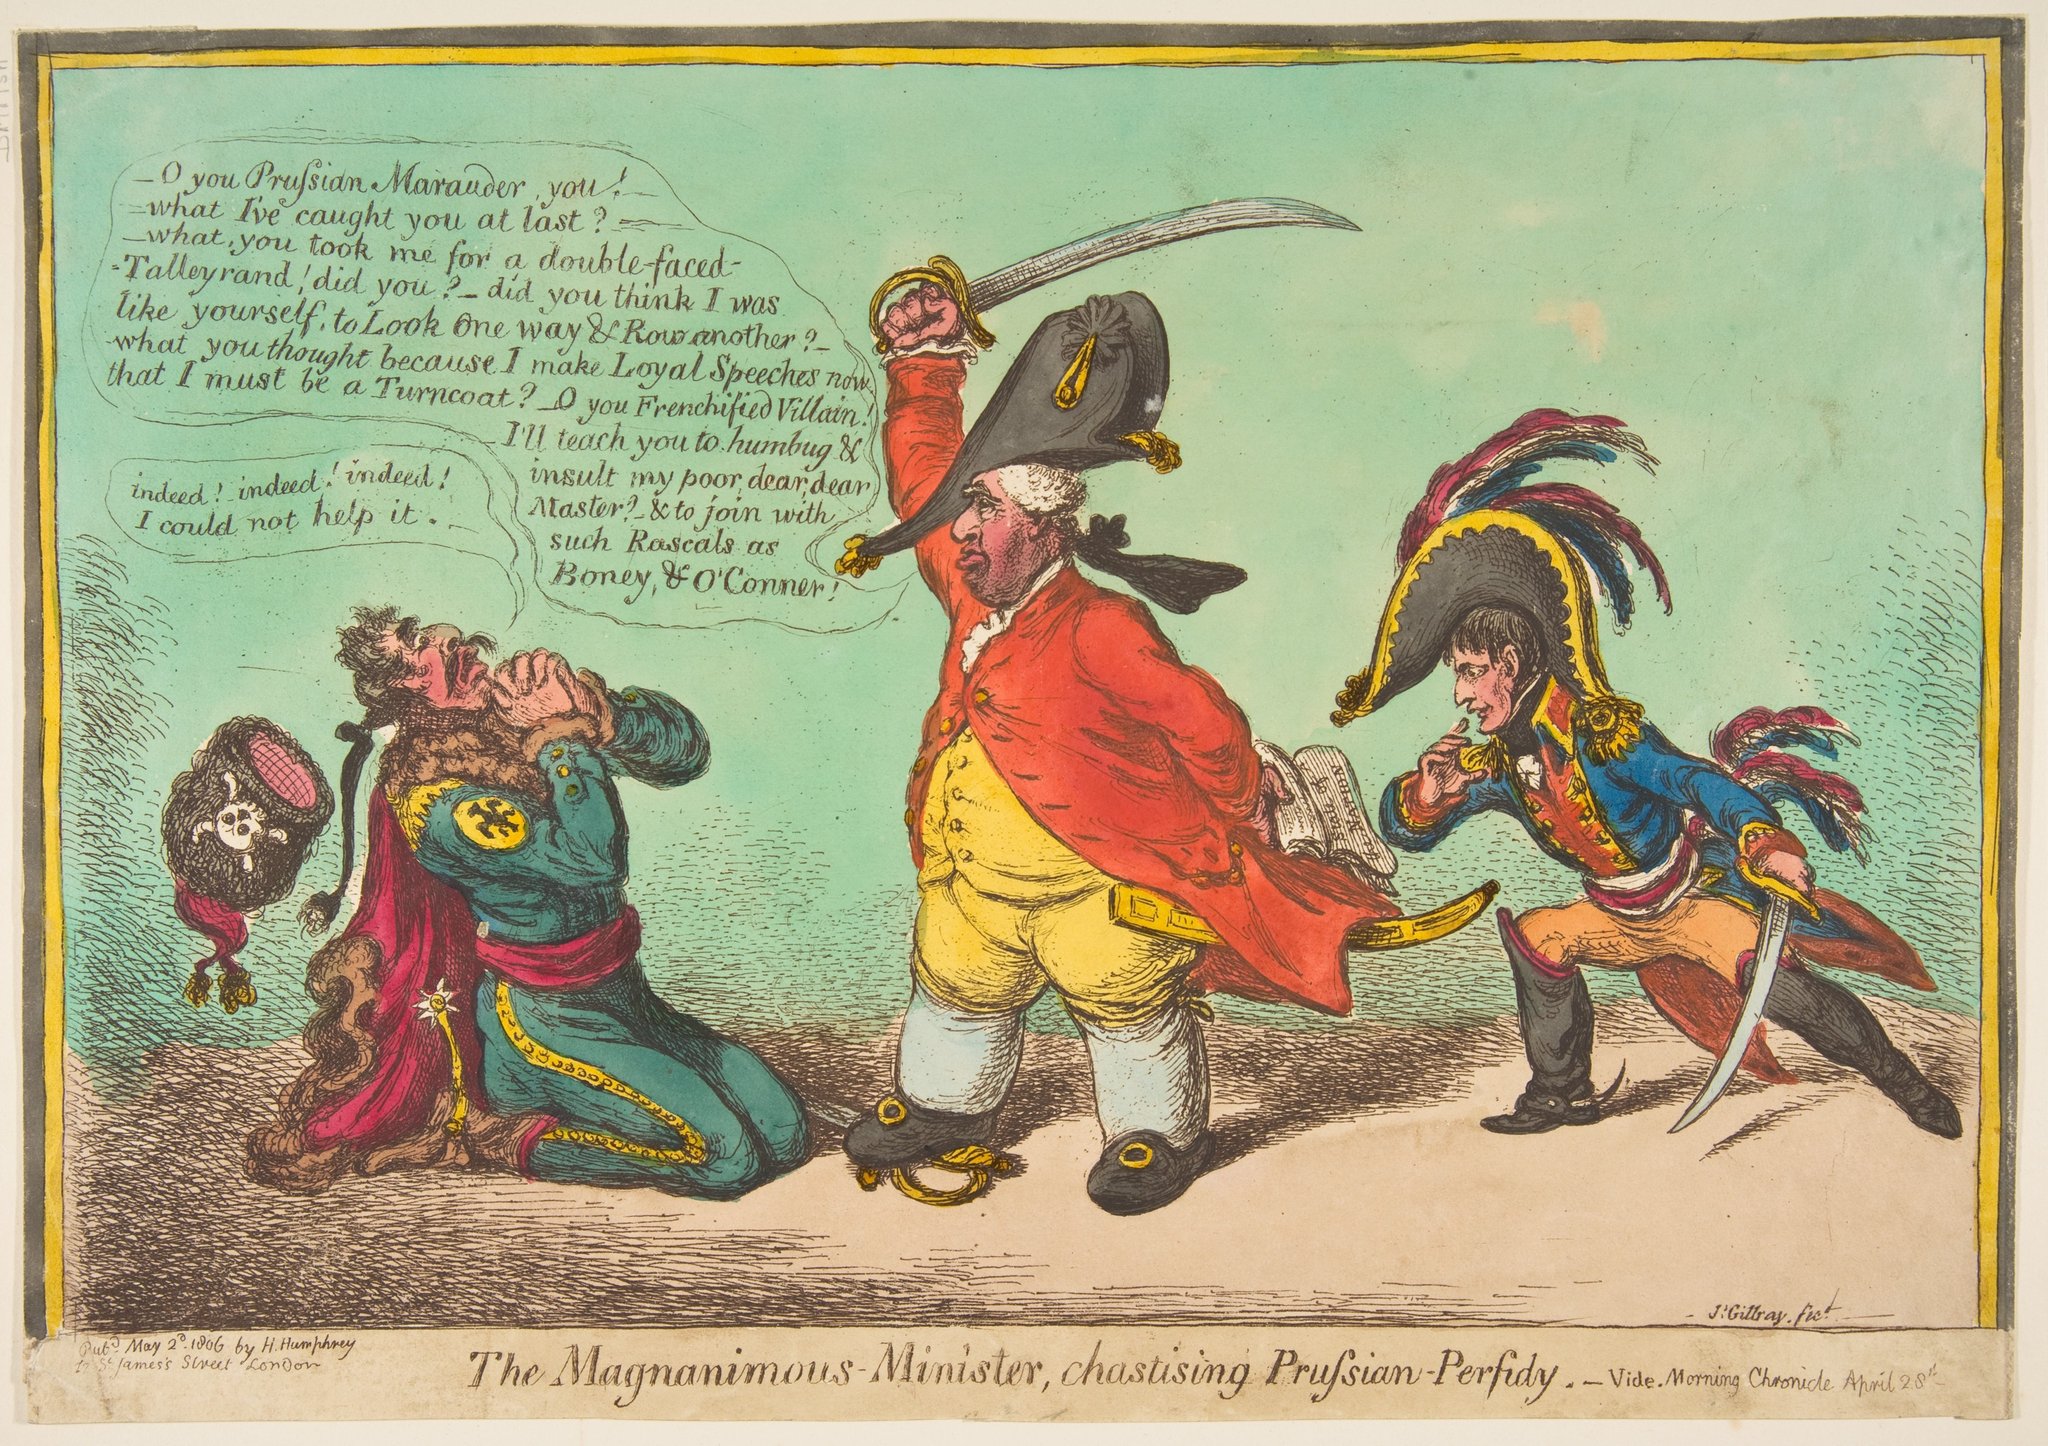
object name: print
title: The Magnanimous–Minster, chastising Prussian–Perfidy.–Vide–Morning Chronicle April 28th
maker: james gillray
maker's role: artist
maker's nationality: british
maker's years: 1756-1815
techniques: etching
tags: satire,men,politics